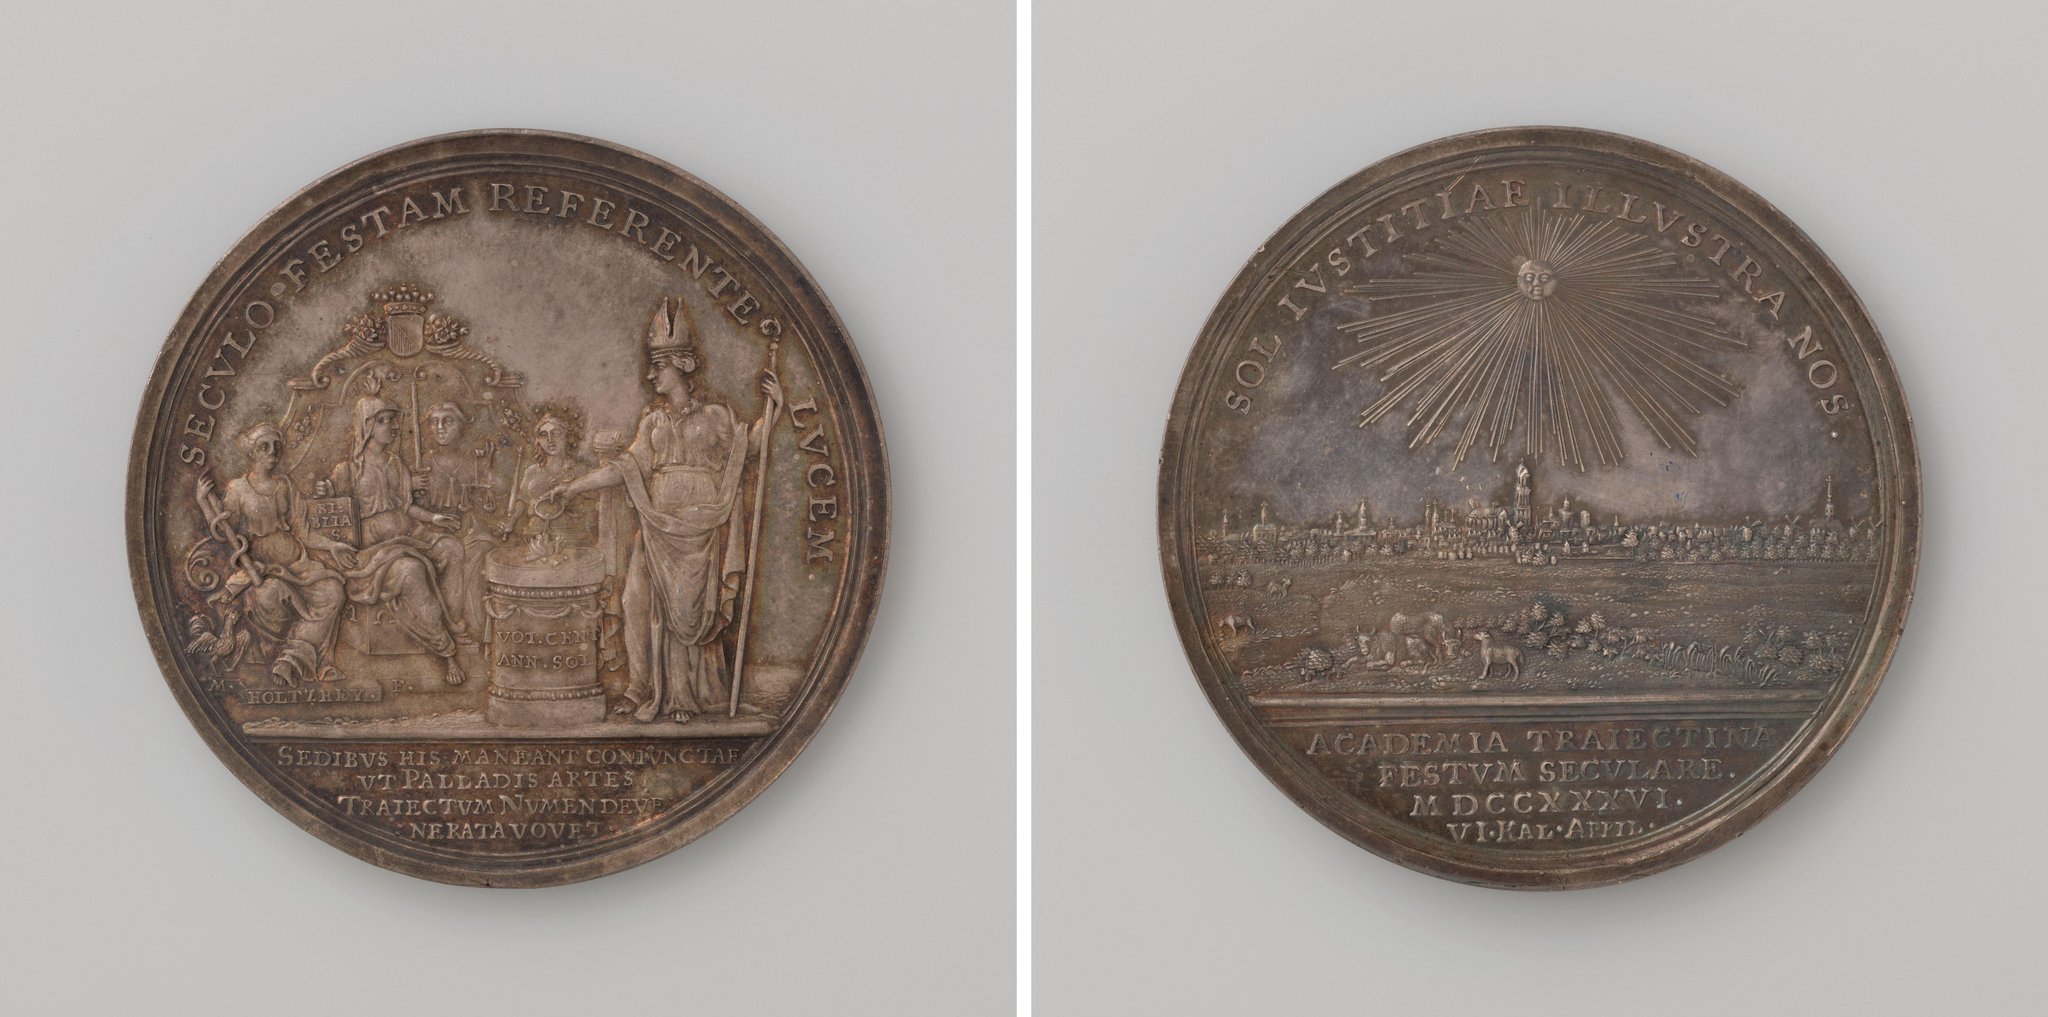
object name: history medal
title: Eeuwfeest van de Hogeschool te Utrecht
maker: martinus holtzhey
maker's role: medailleur, muntmaker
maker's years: 1697-1764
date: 1736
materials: silver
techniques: striking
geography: amsterdam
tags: utrecht